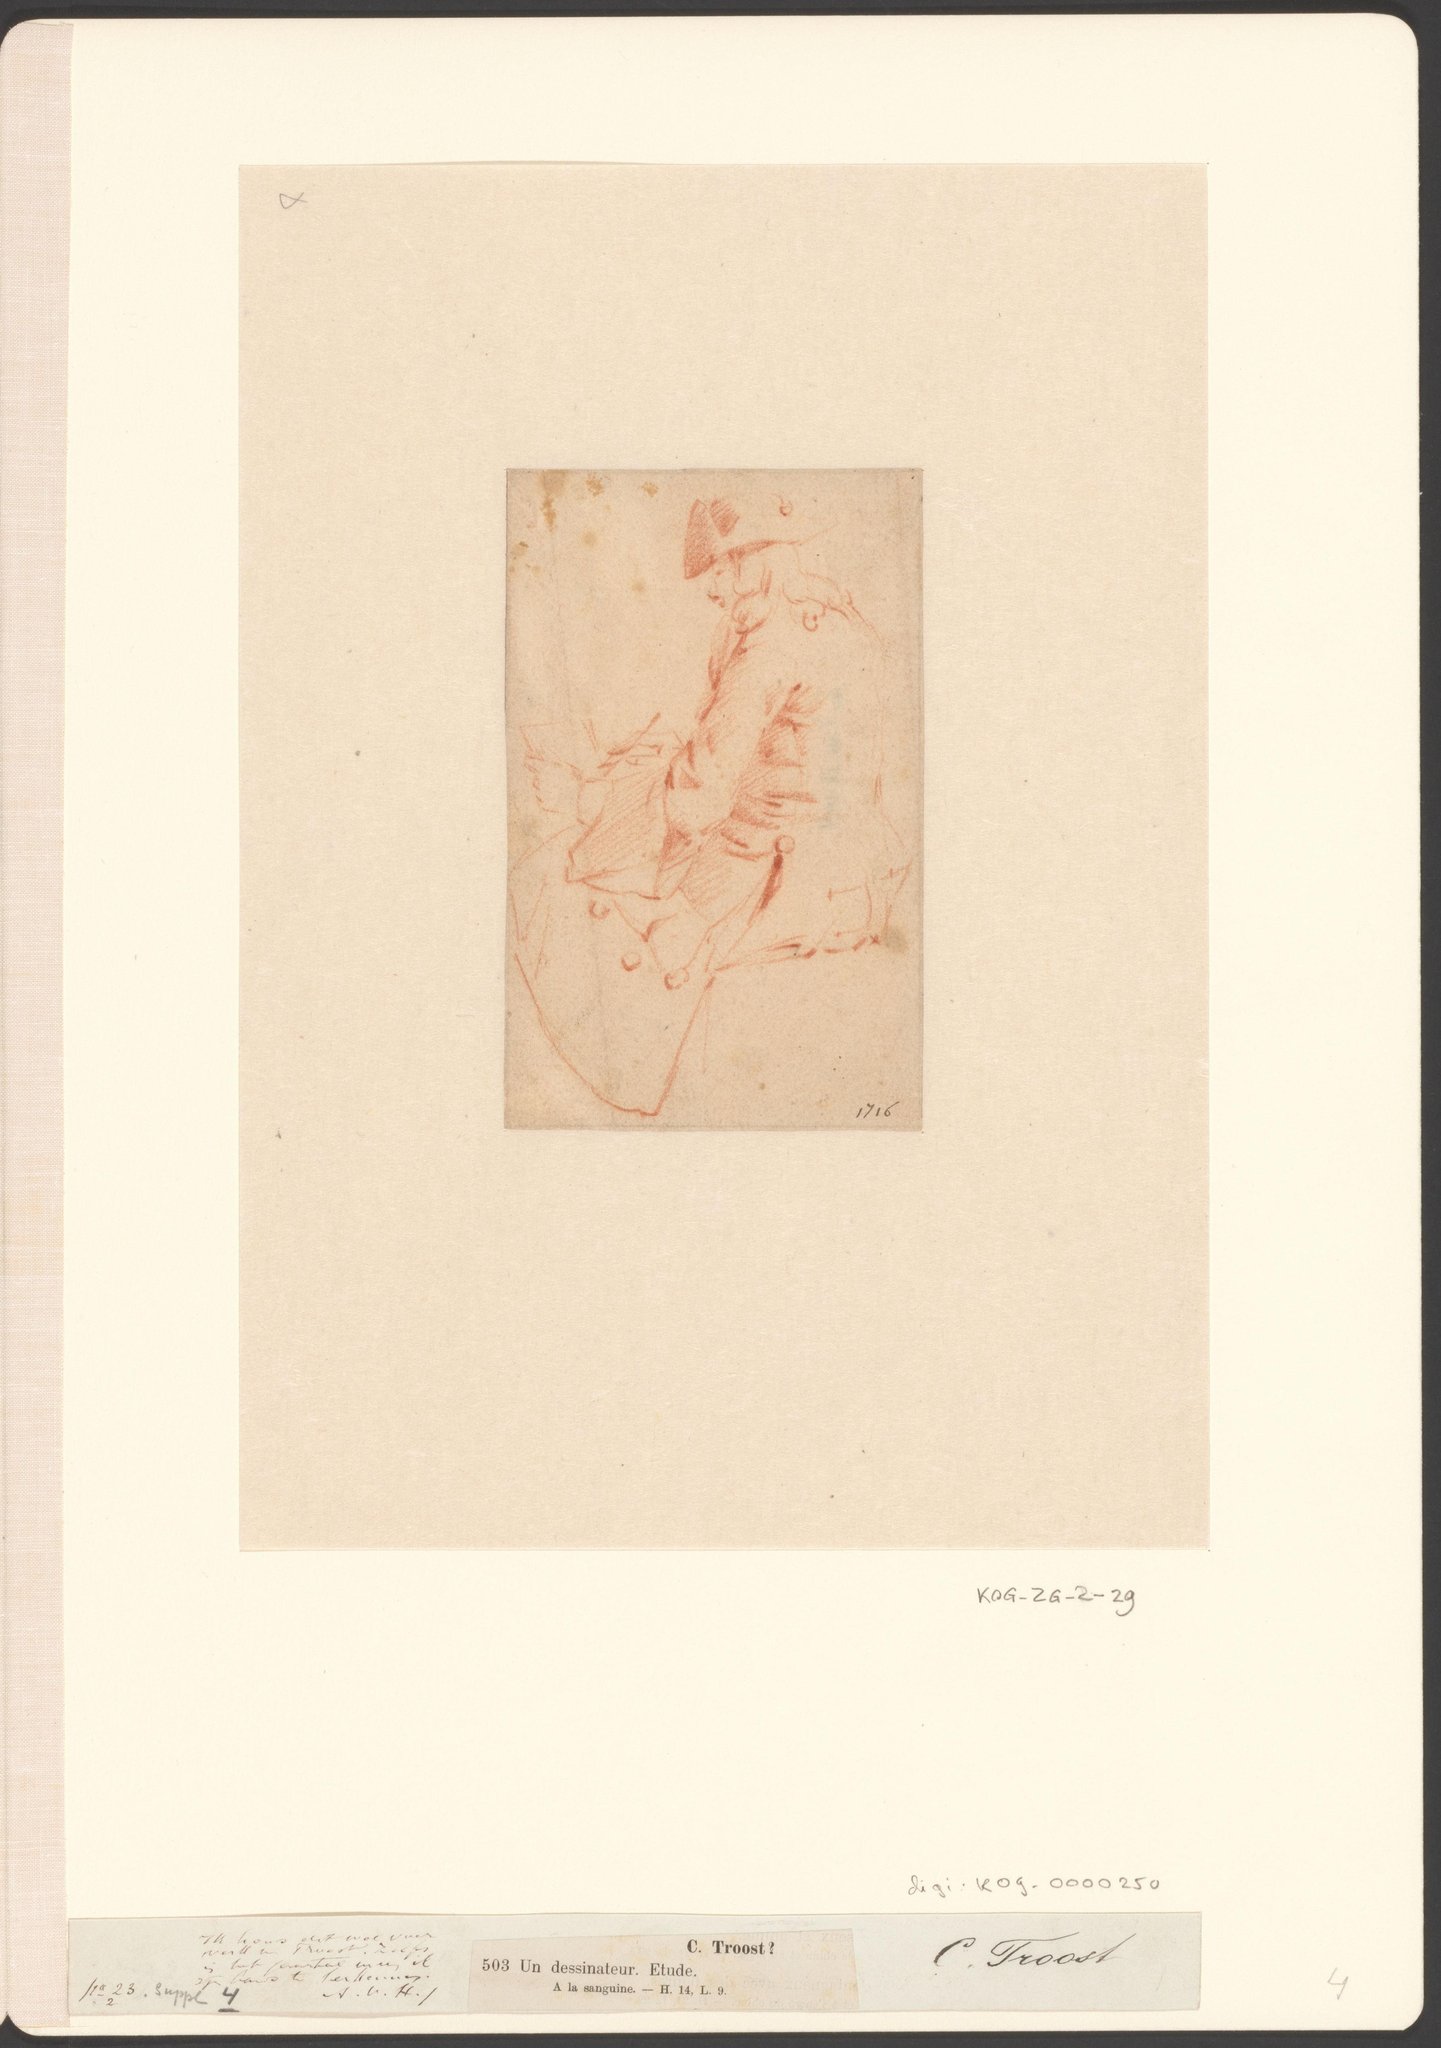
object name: drawing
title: Zittende tekenaar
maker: cornelis troost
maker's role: draughtsman, painter, print maker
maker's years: 1696-1750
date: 1716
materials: chalk, paper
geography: netherlands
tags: sitting figure, draughtsman at work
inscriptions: collector's mark: Lugt 2488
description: Studie van een zittende man, aan het tekenen. Driekwart van achteren gezien.